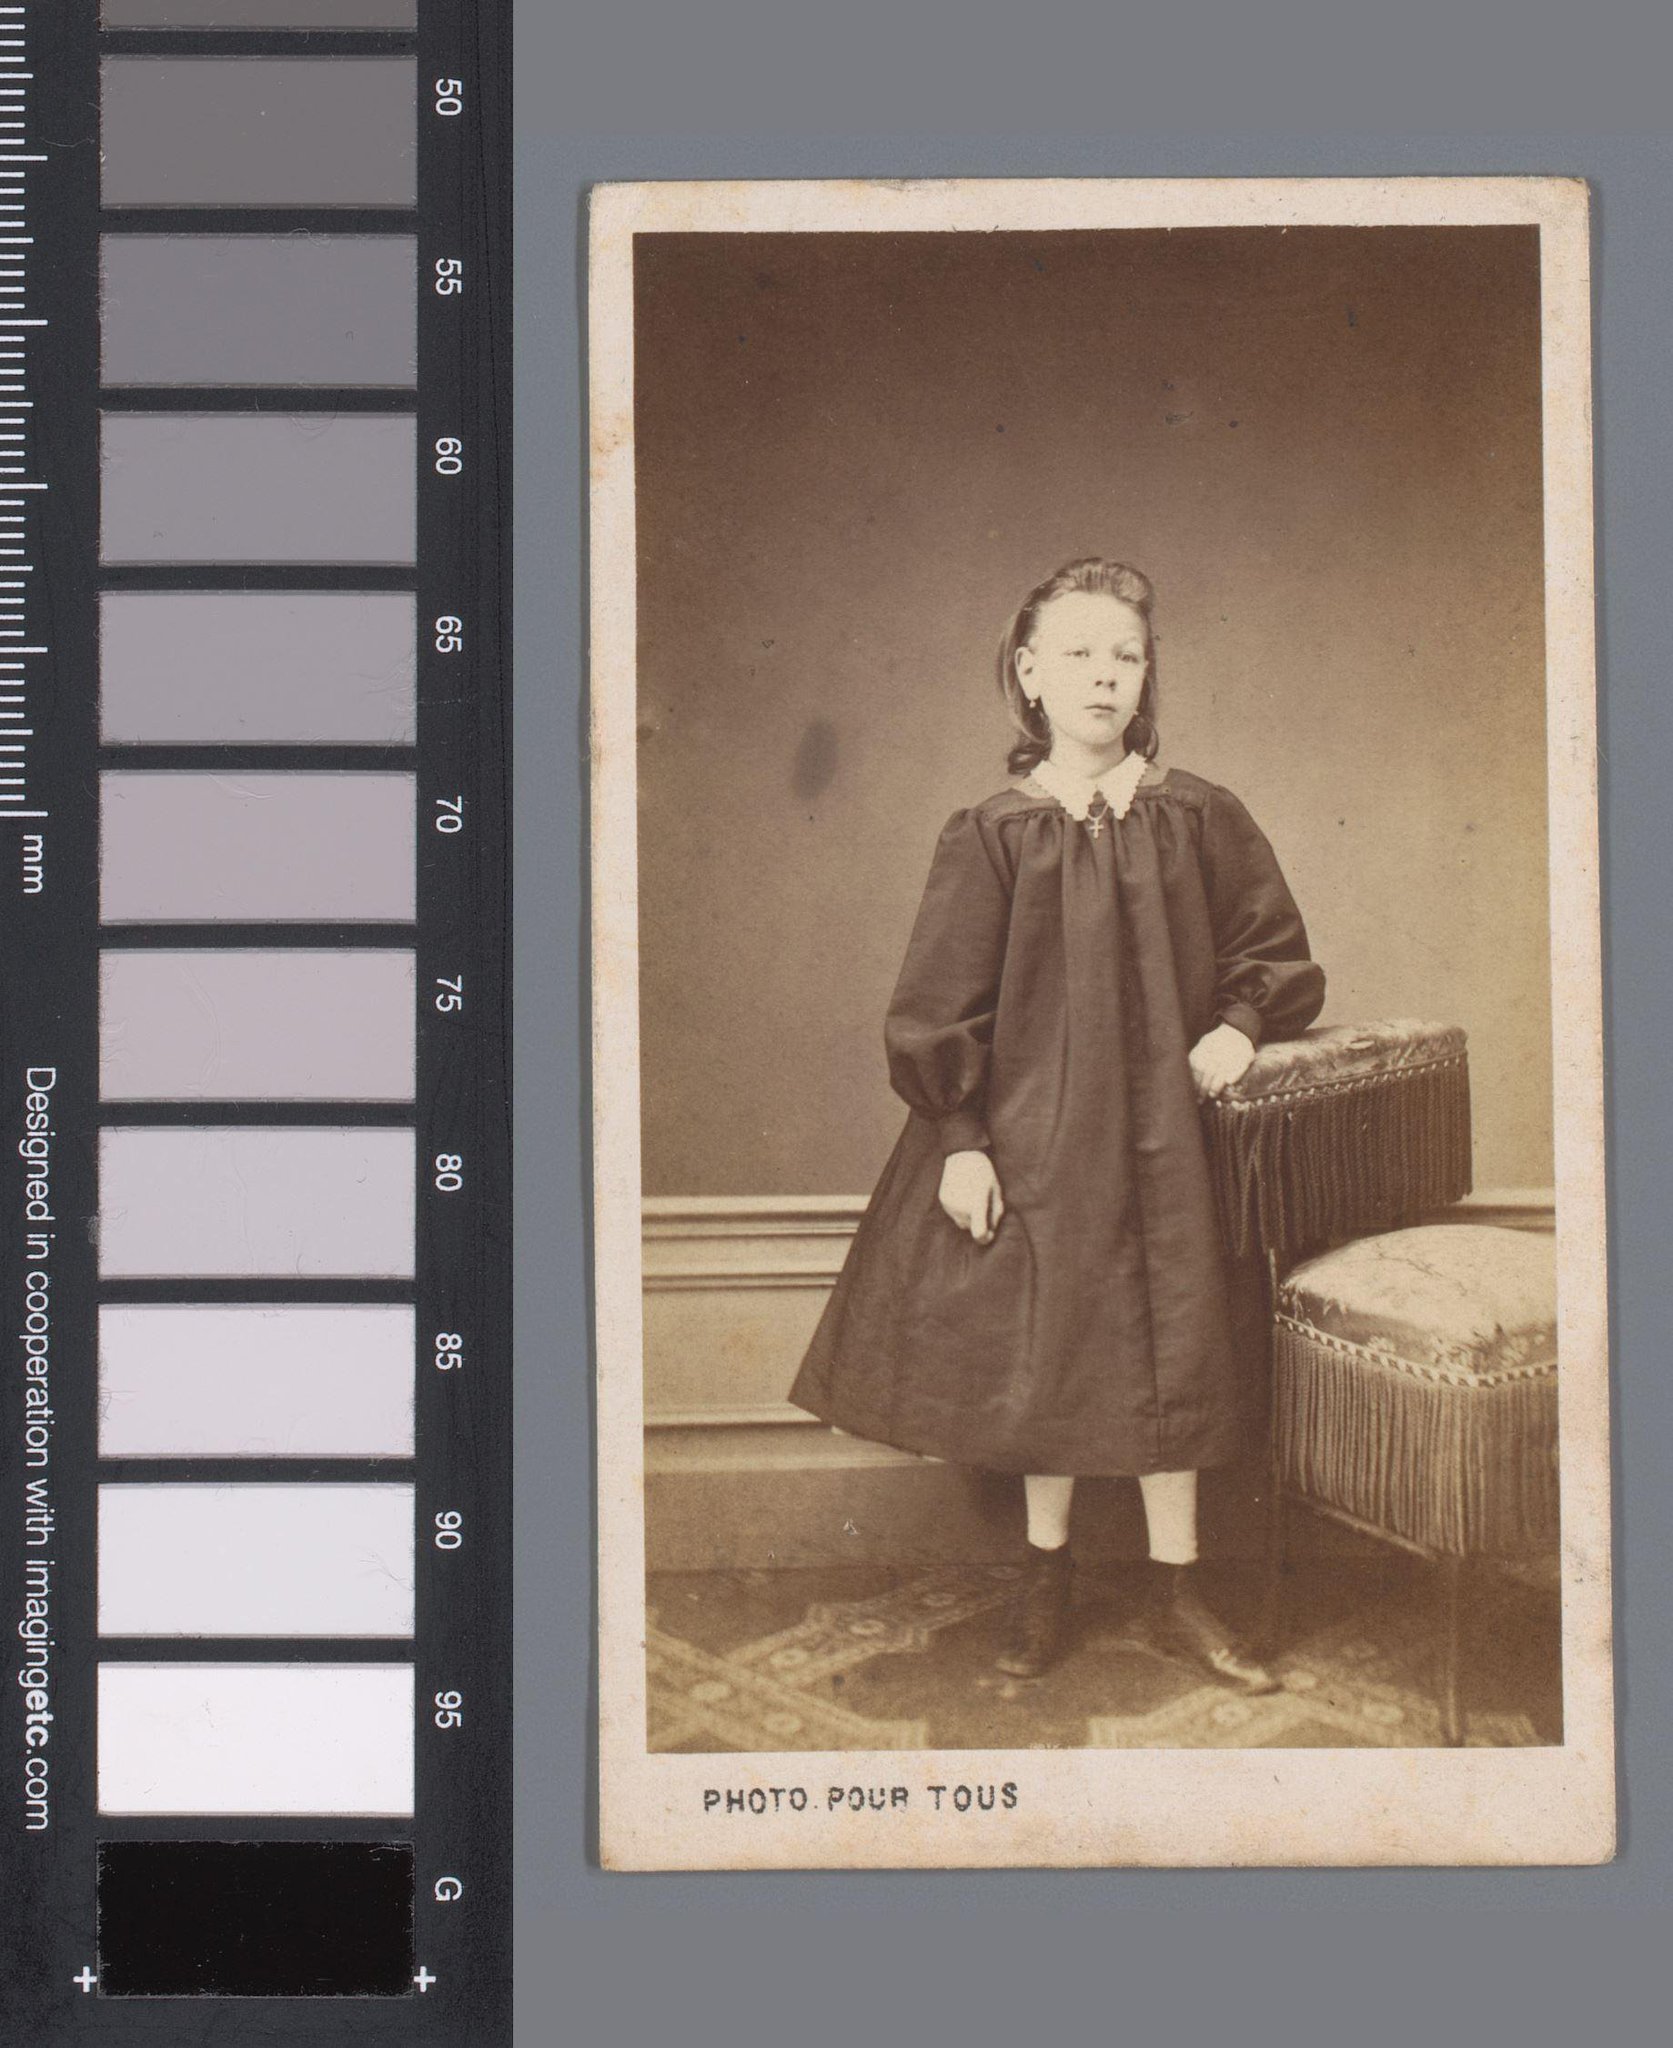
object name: photograph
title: Portret van een onbekend meisje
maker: paul arthur crosnier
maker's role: fotograaf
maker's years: 1835-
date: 1865-1884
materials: cardboard, paper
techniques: albumen print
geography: paris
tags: girl (child between toddler and youth), anonymous historical person portrayed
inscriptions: inscription: ‘PHOTOGRAPHIE POUR TOUS/ MÉDAILLE D'ARGENT/ A. CROSNIER/ PEINTRE ET PHOTOGRAPHE/ CLICHÉ/ Il suffit de rappeler ce No./ pour une nouvelle commande.’, address: ‘B.art de Strasbourg/ 41/ AU 1er ÉTAGE/ PARIS’